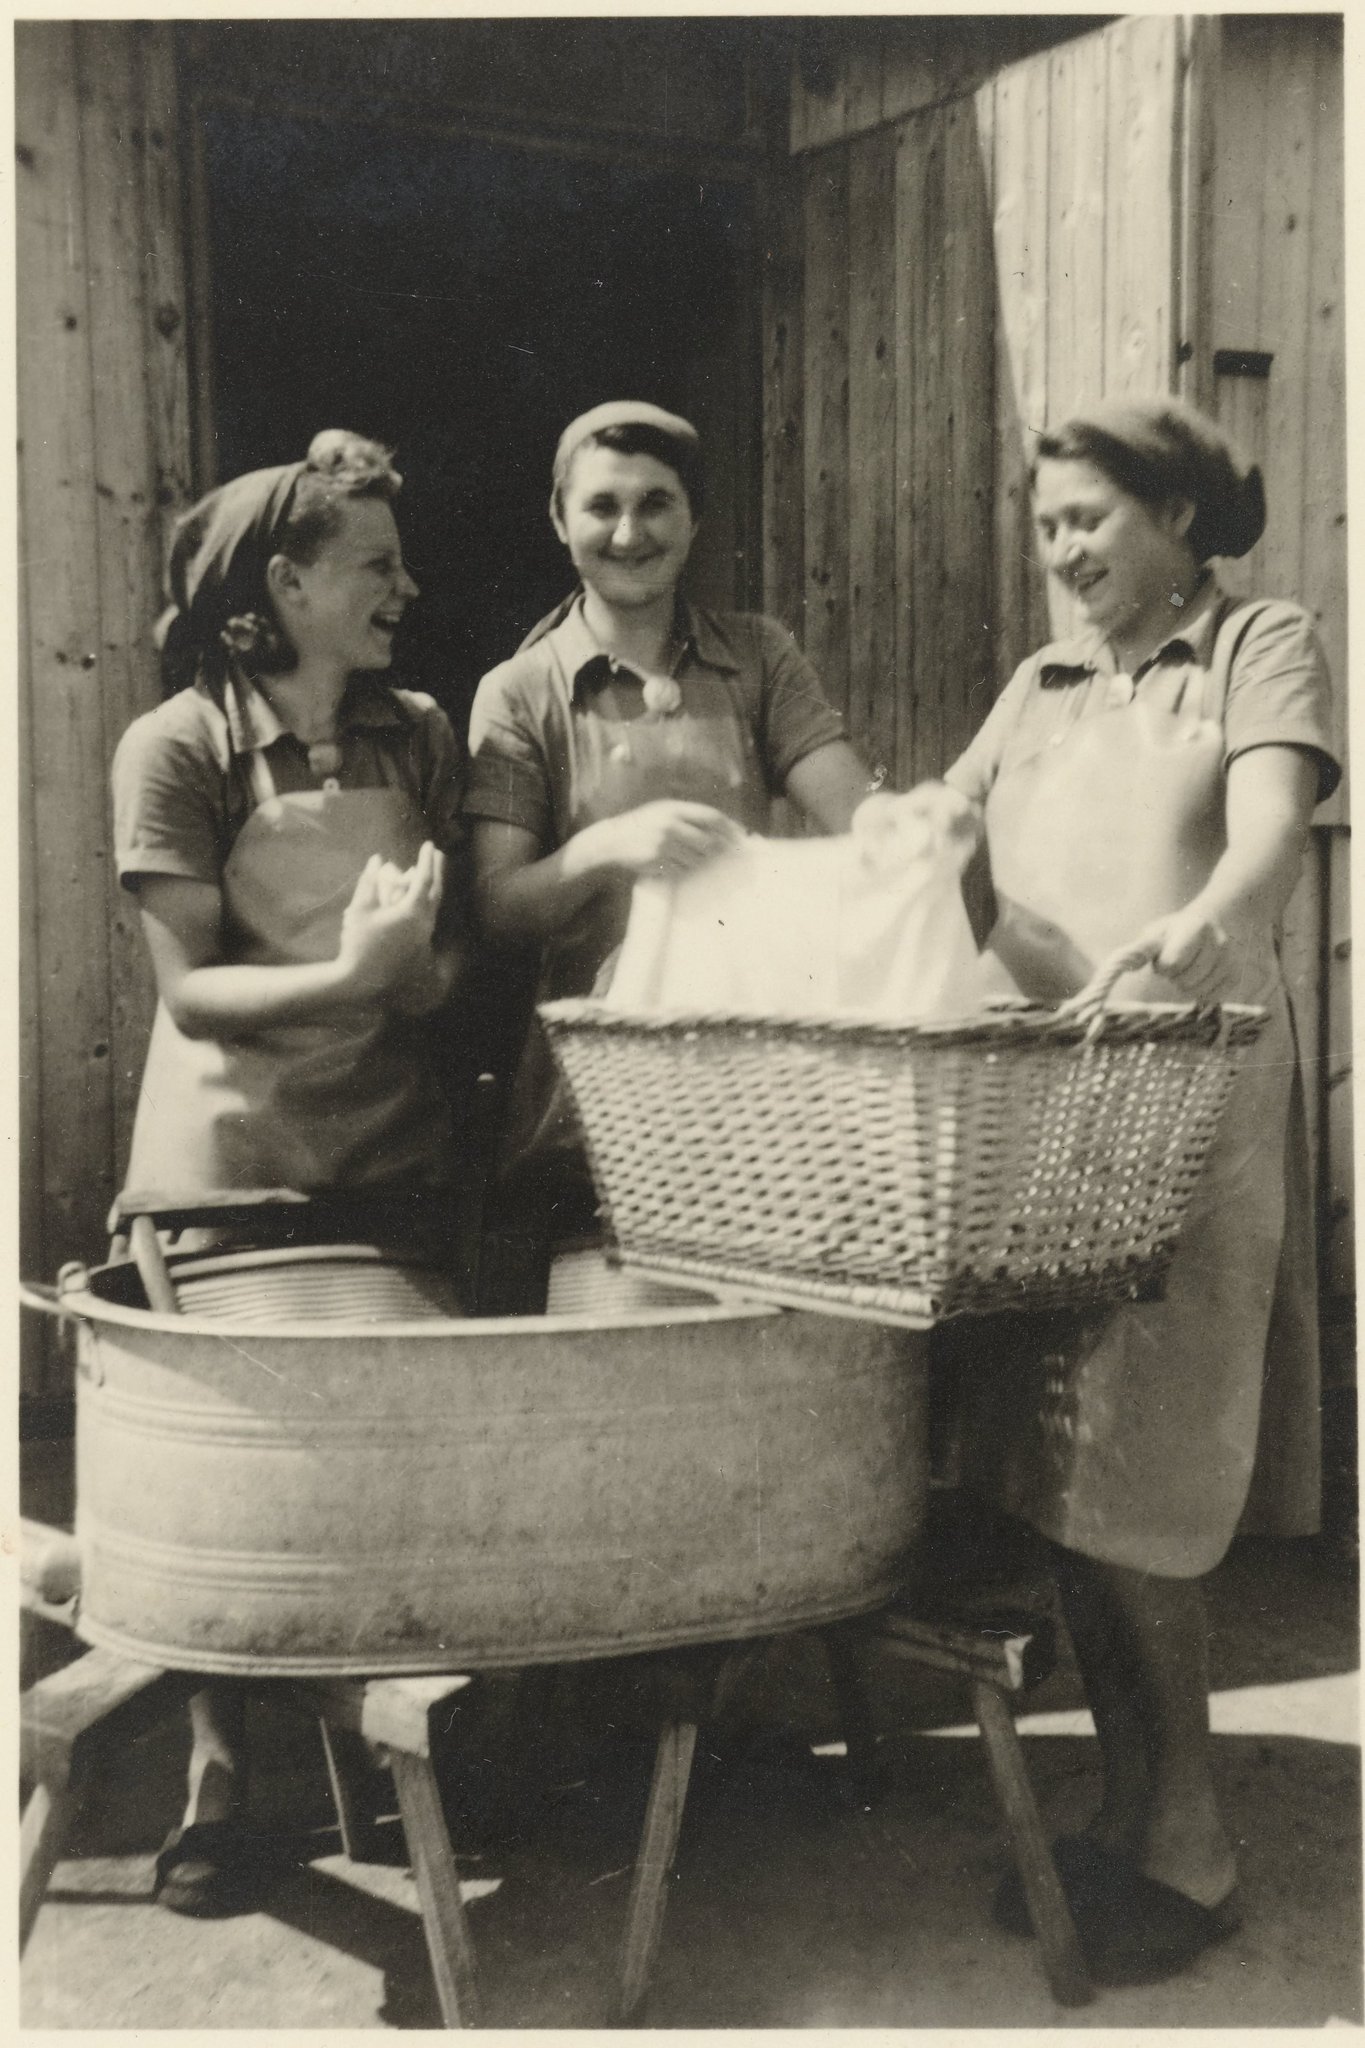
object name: photograph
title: Wasvrouwen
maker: Anonymous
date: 1940-1945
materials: photographic support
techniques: gelatin silver print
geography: netherlands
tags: germany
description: Drie dames zijn bezig met de was in een tobbe. Een van hen heeft een wasmand vast. Foto behorend bij album 'Kriegserinnerungen'.